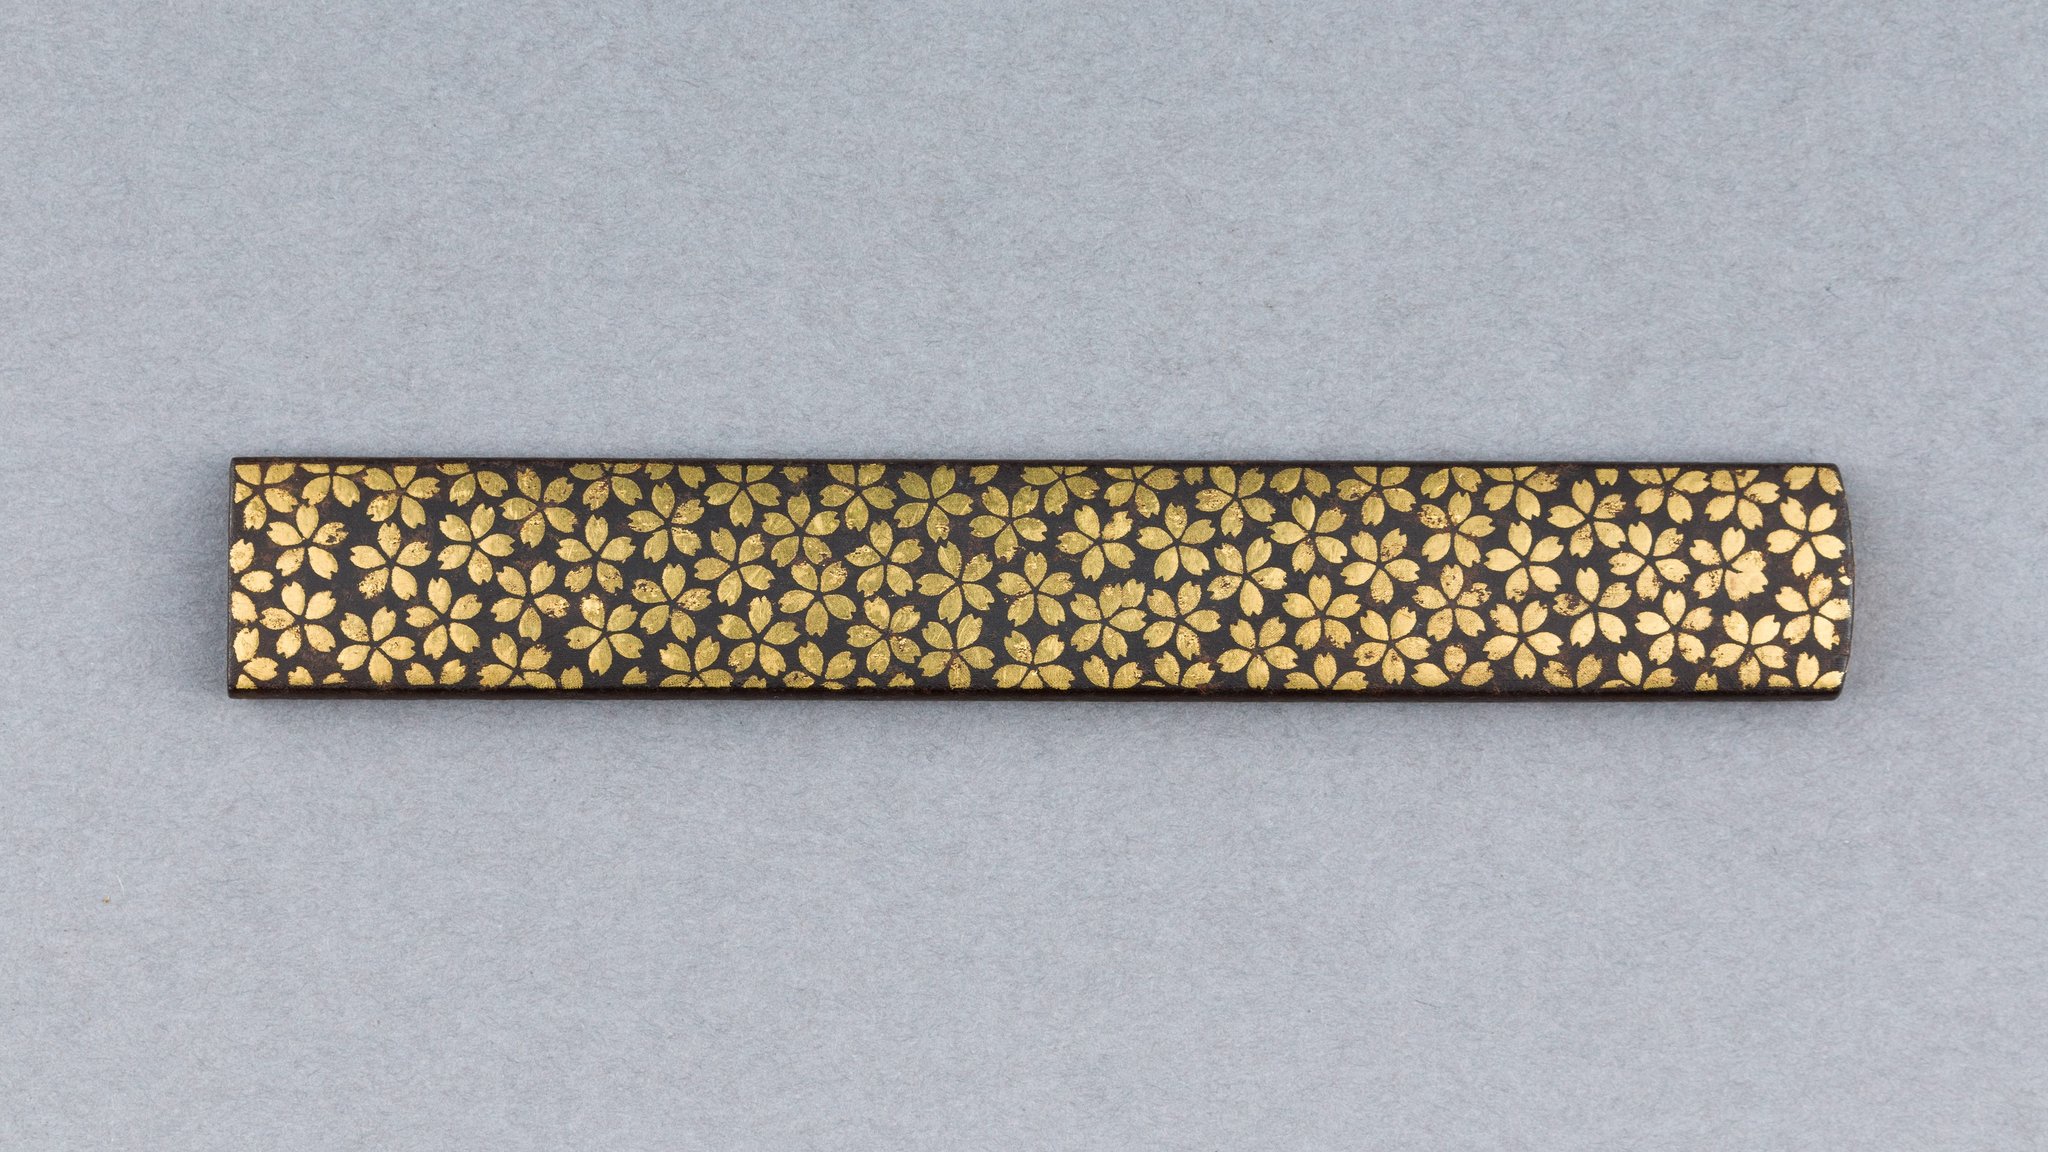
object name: knife handle kozuka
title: Knife Handle (Kozuka)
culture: japanese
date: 1615-1868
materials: silver alloy, gold, iron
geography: japan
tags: flowers